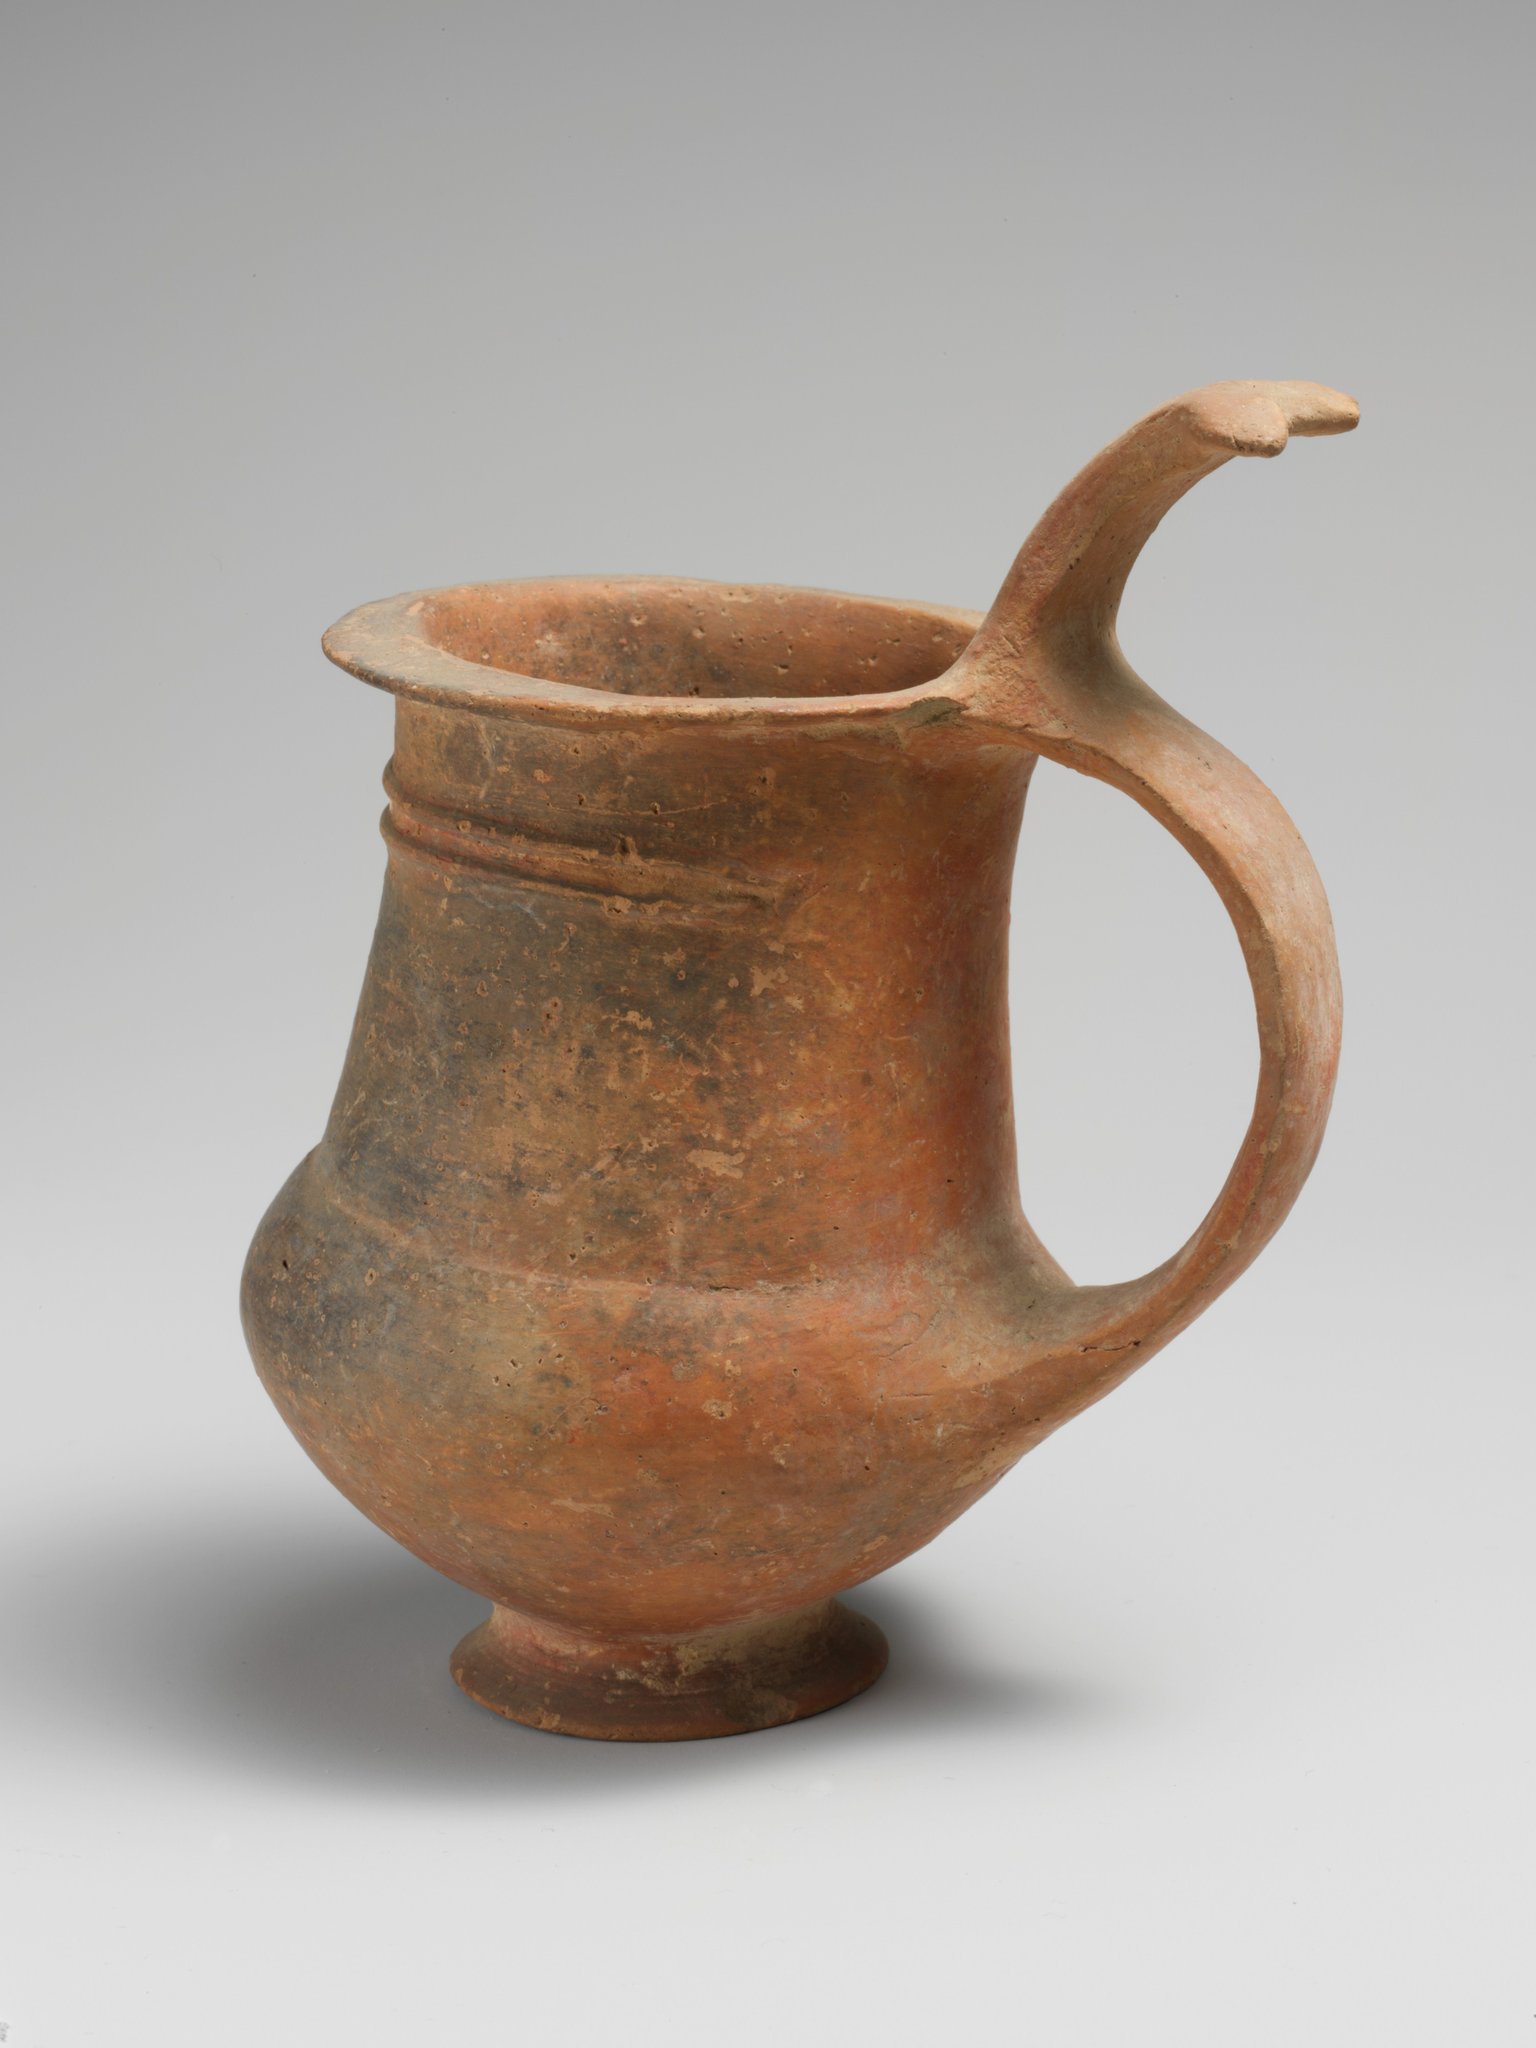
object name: tankard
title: Terracotta tankard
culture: cypriot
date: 1600-1200 BCE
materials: terracotta